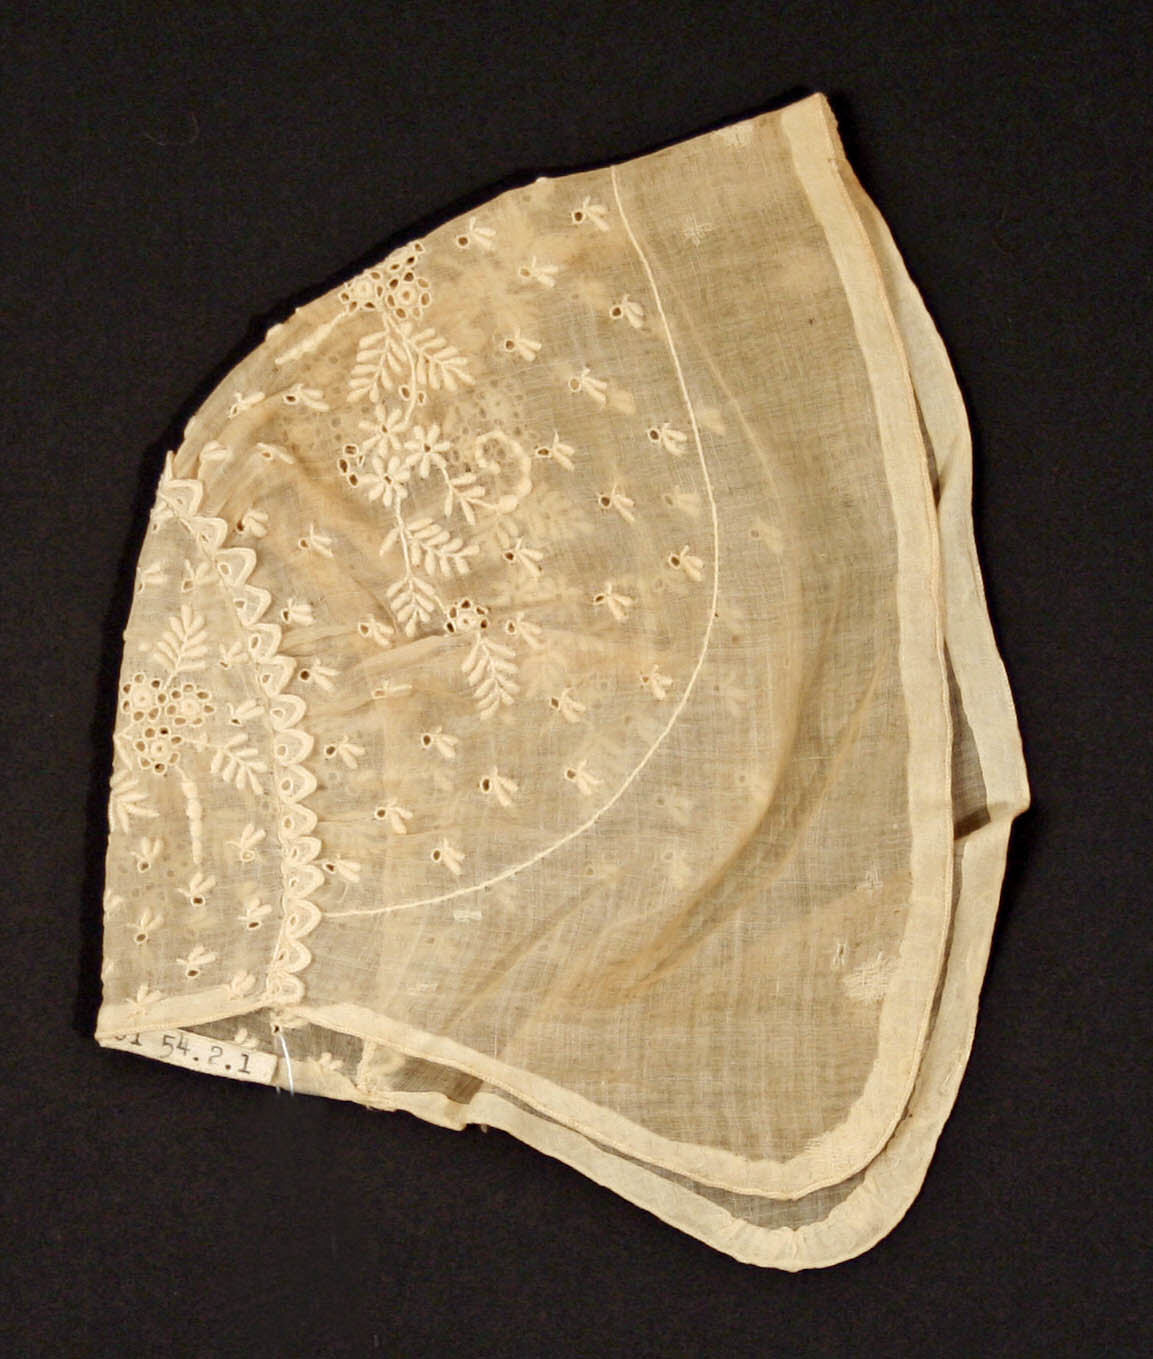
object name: christening cap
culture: american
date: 1861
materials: cotton